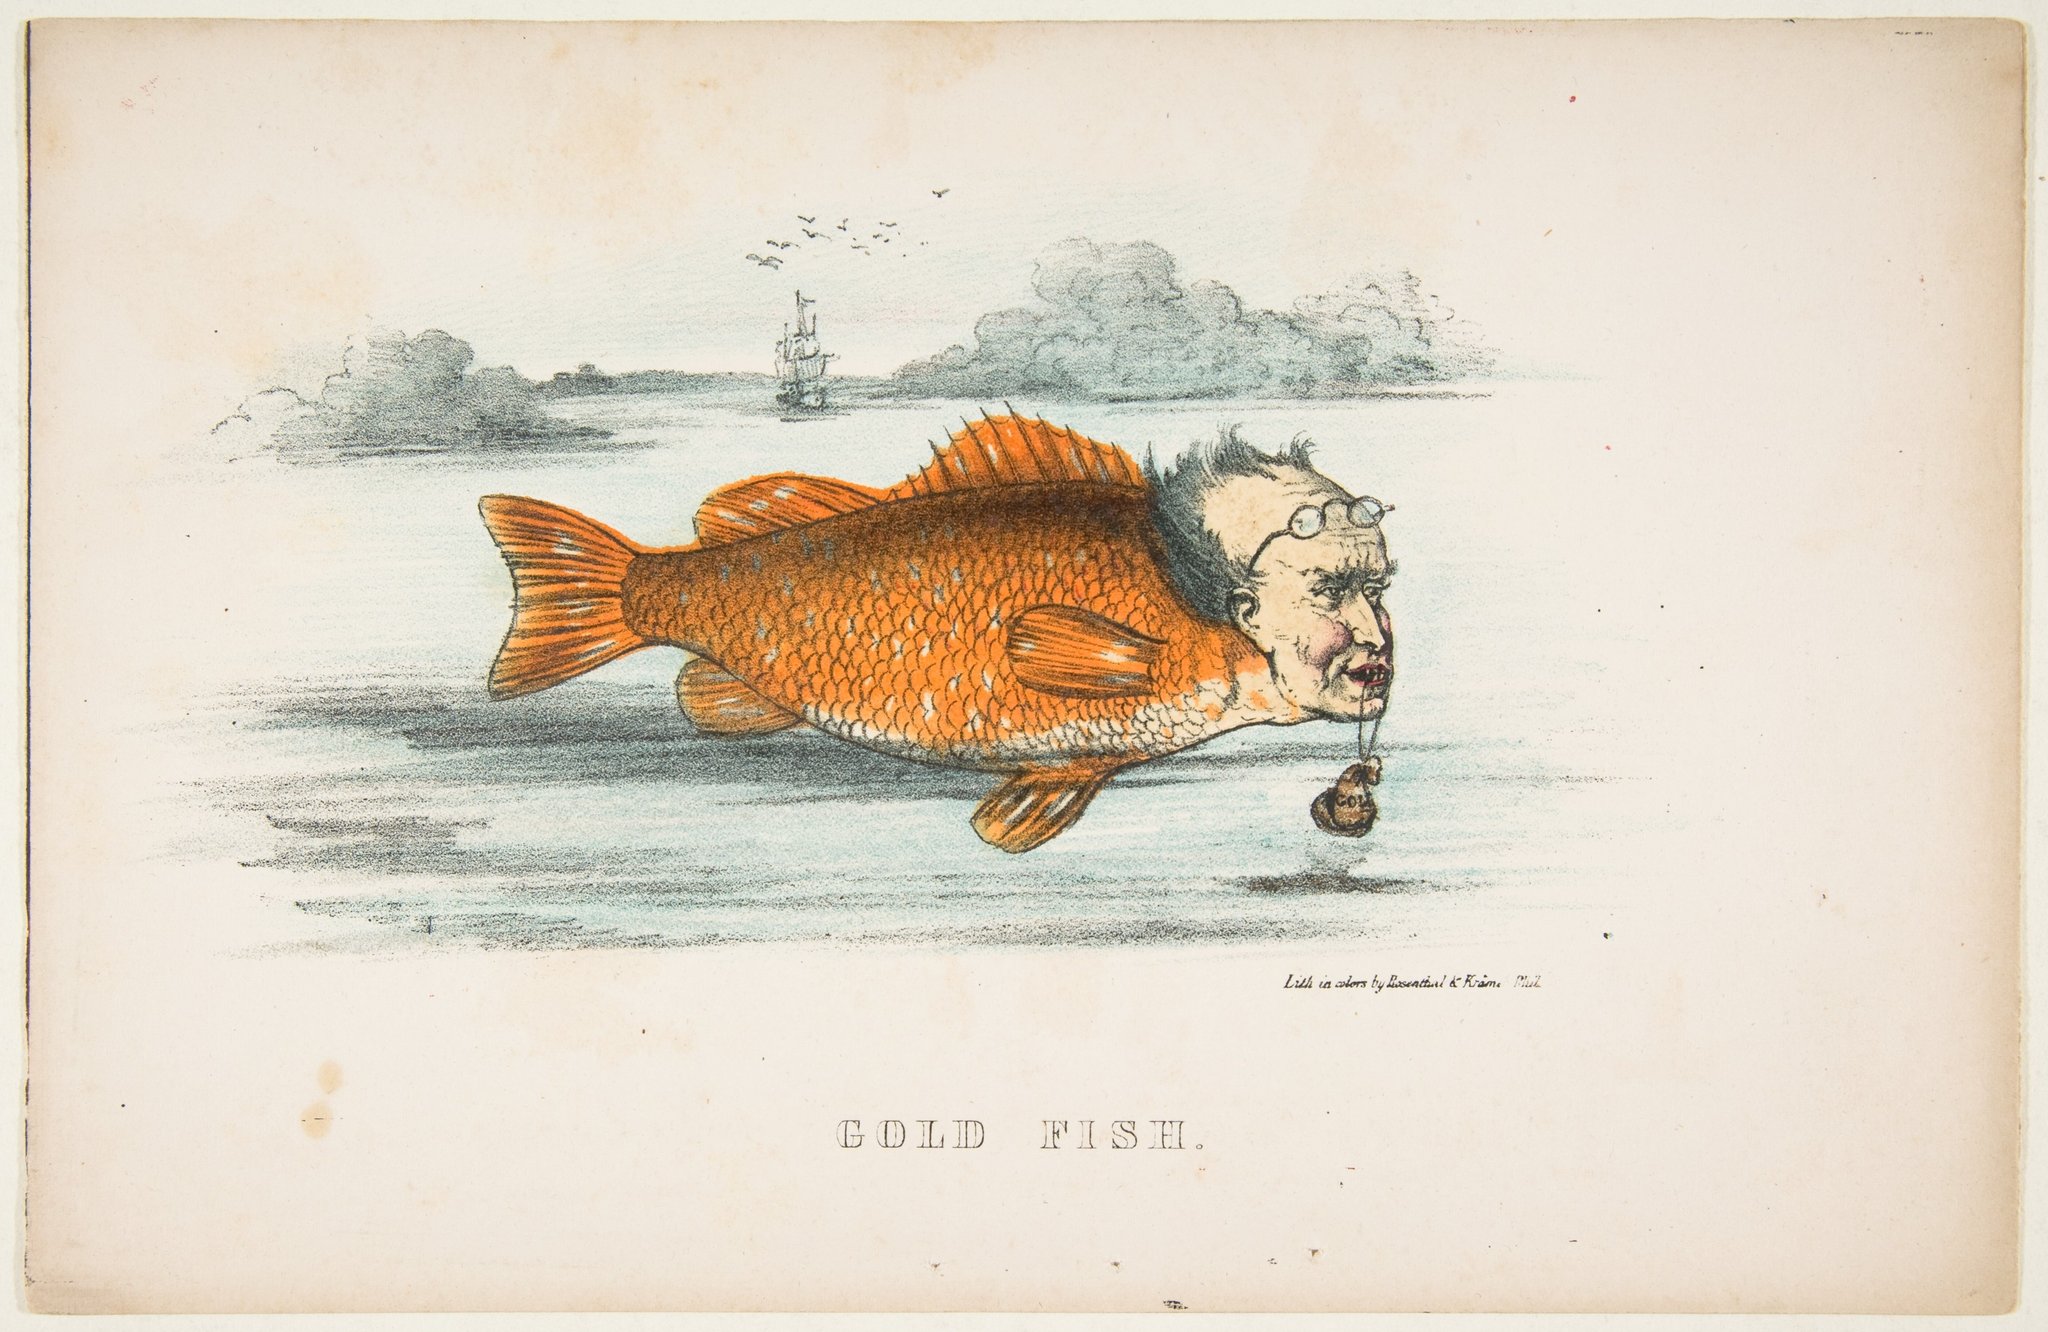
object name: print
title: Gold Fish (Francis M. Drexel), from "The Comic Natural History of the Human Race"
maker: henry louis stephens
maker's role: artist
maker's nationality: american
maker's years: 1824-1882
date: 1851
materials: watercolor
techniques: lithograph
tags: fish,caricature